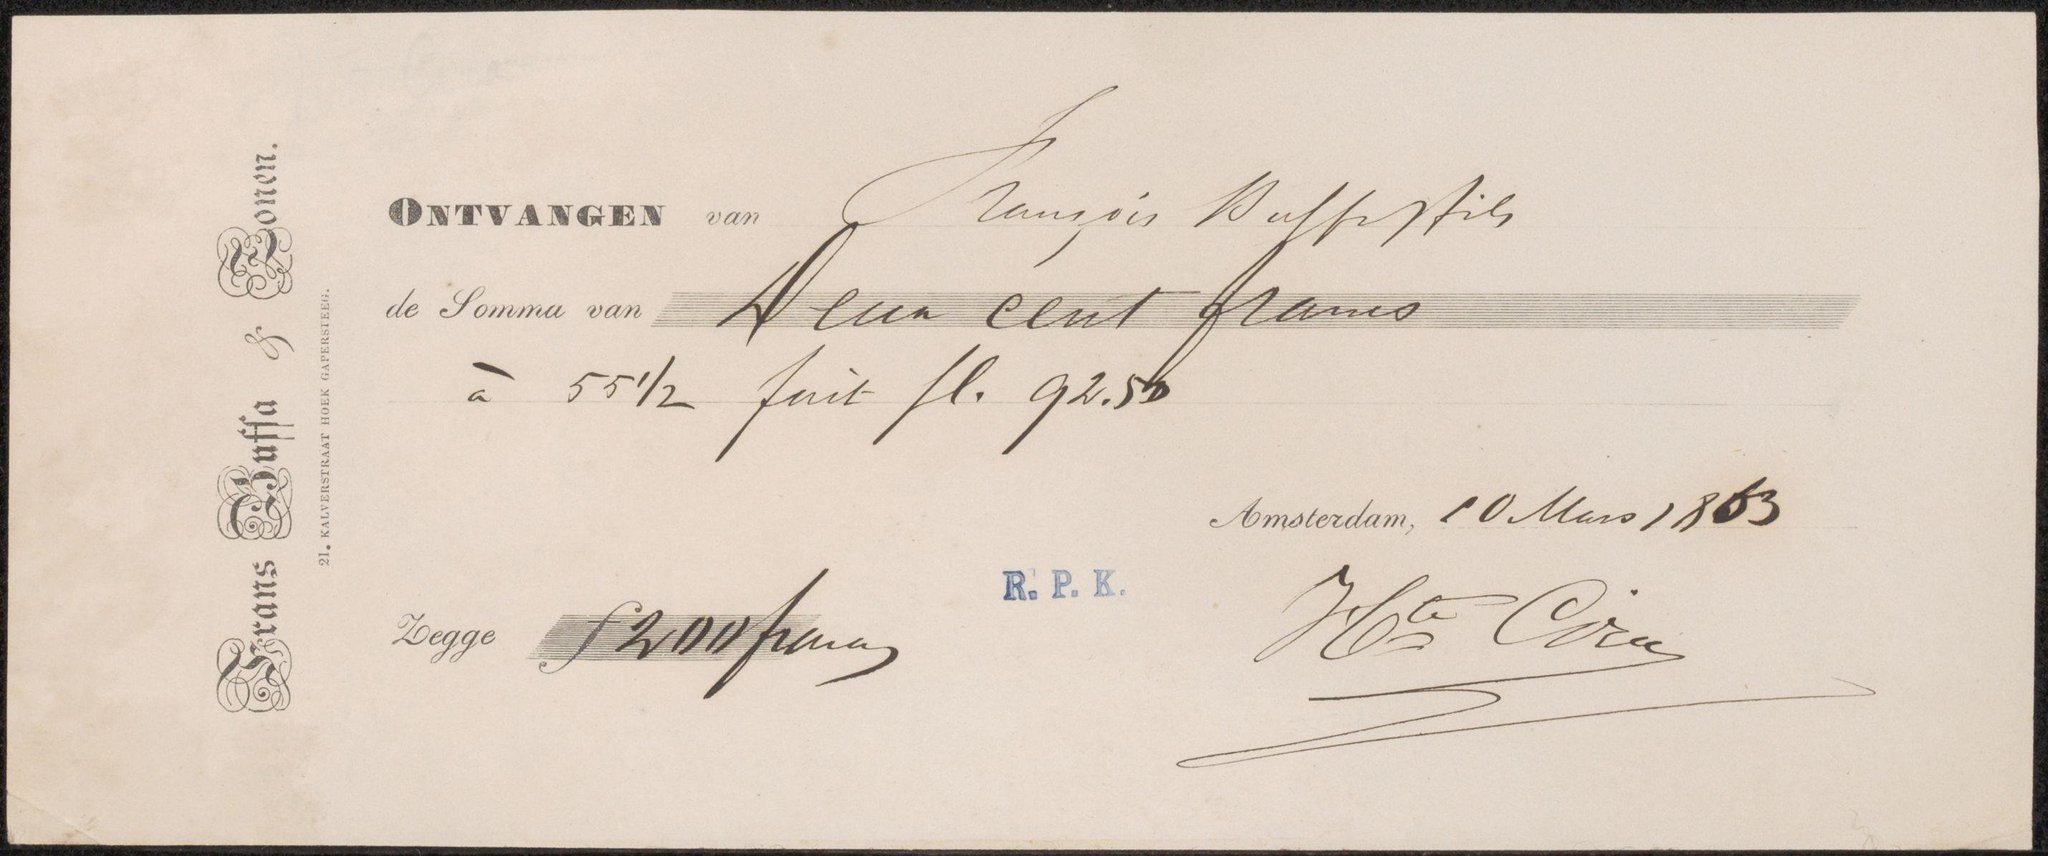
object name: ontvangstbewijs, kwitantie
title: Kwitantie voor onbekend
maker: Anonymous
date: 1863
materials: ink, paper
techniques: pen, printing, writing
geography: amsterdam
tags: money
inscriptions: collector's mark: Lugt 2233